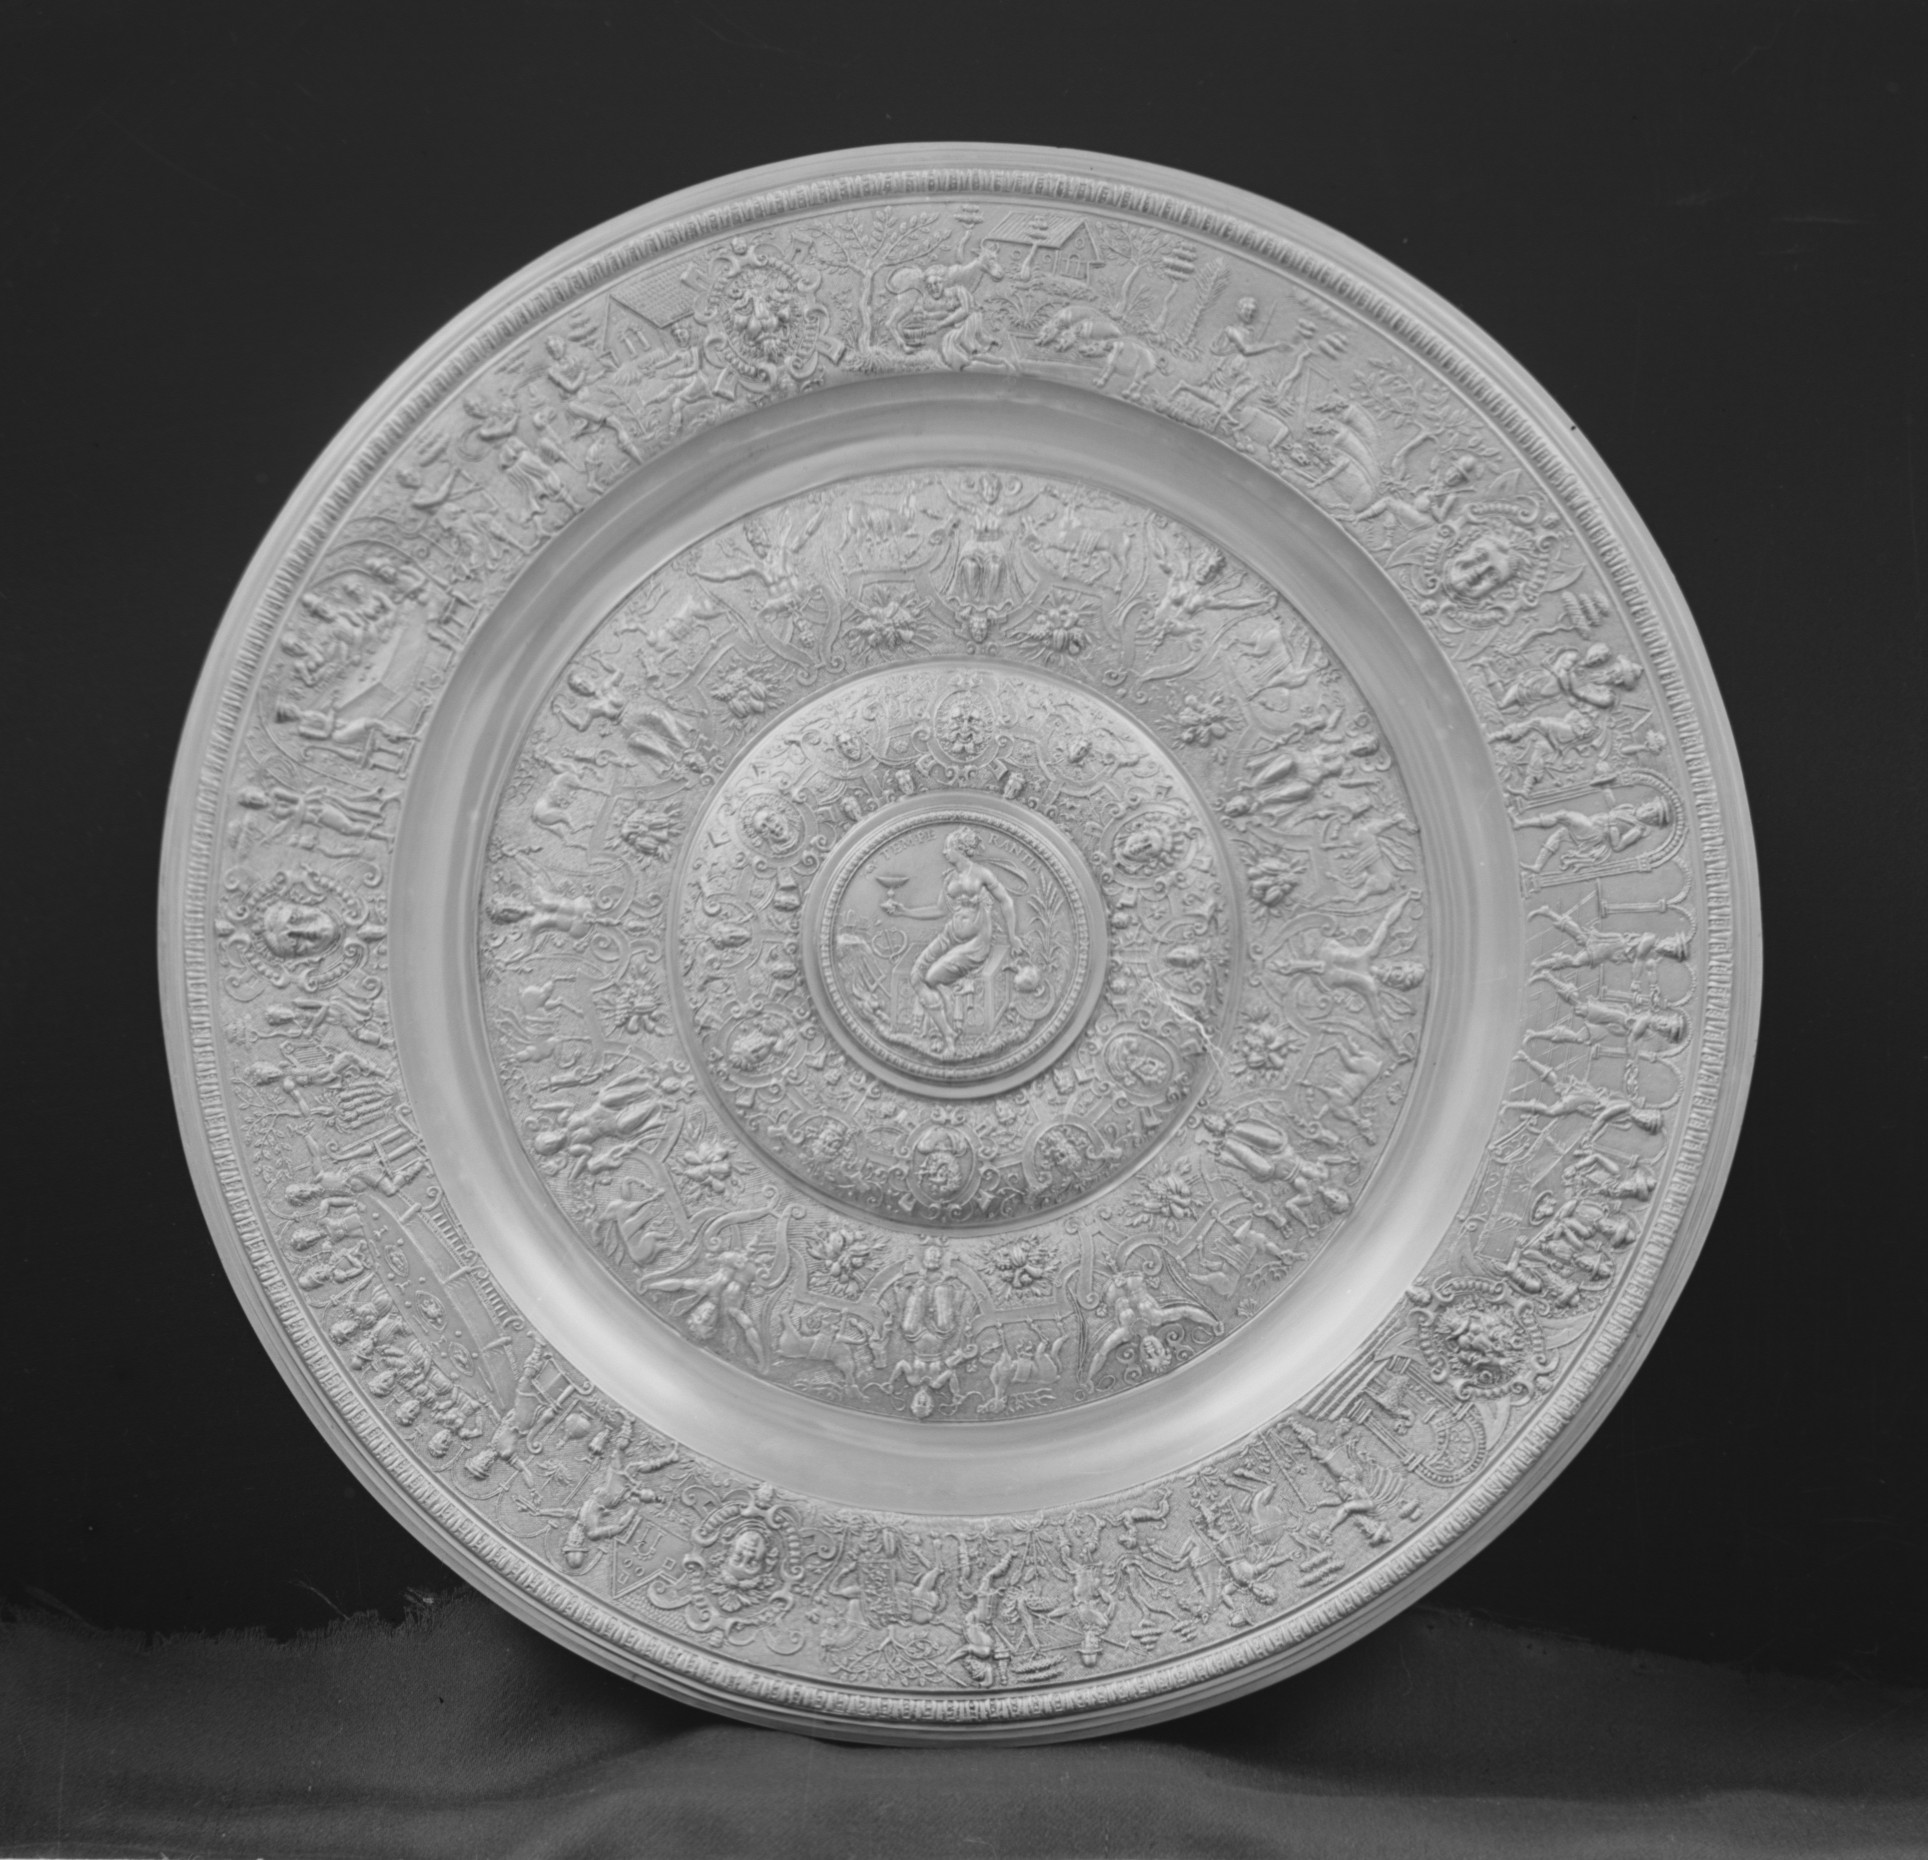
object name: plateau or salver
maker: kasper enderlein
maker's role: artist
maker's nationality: german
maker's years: 1560-1633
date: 1801-1900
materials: pewter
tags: women